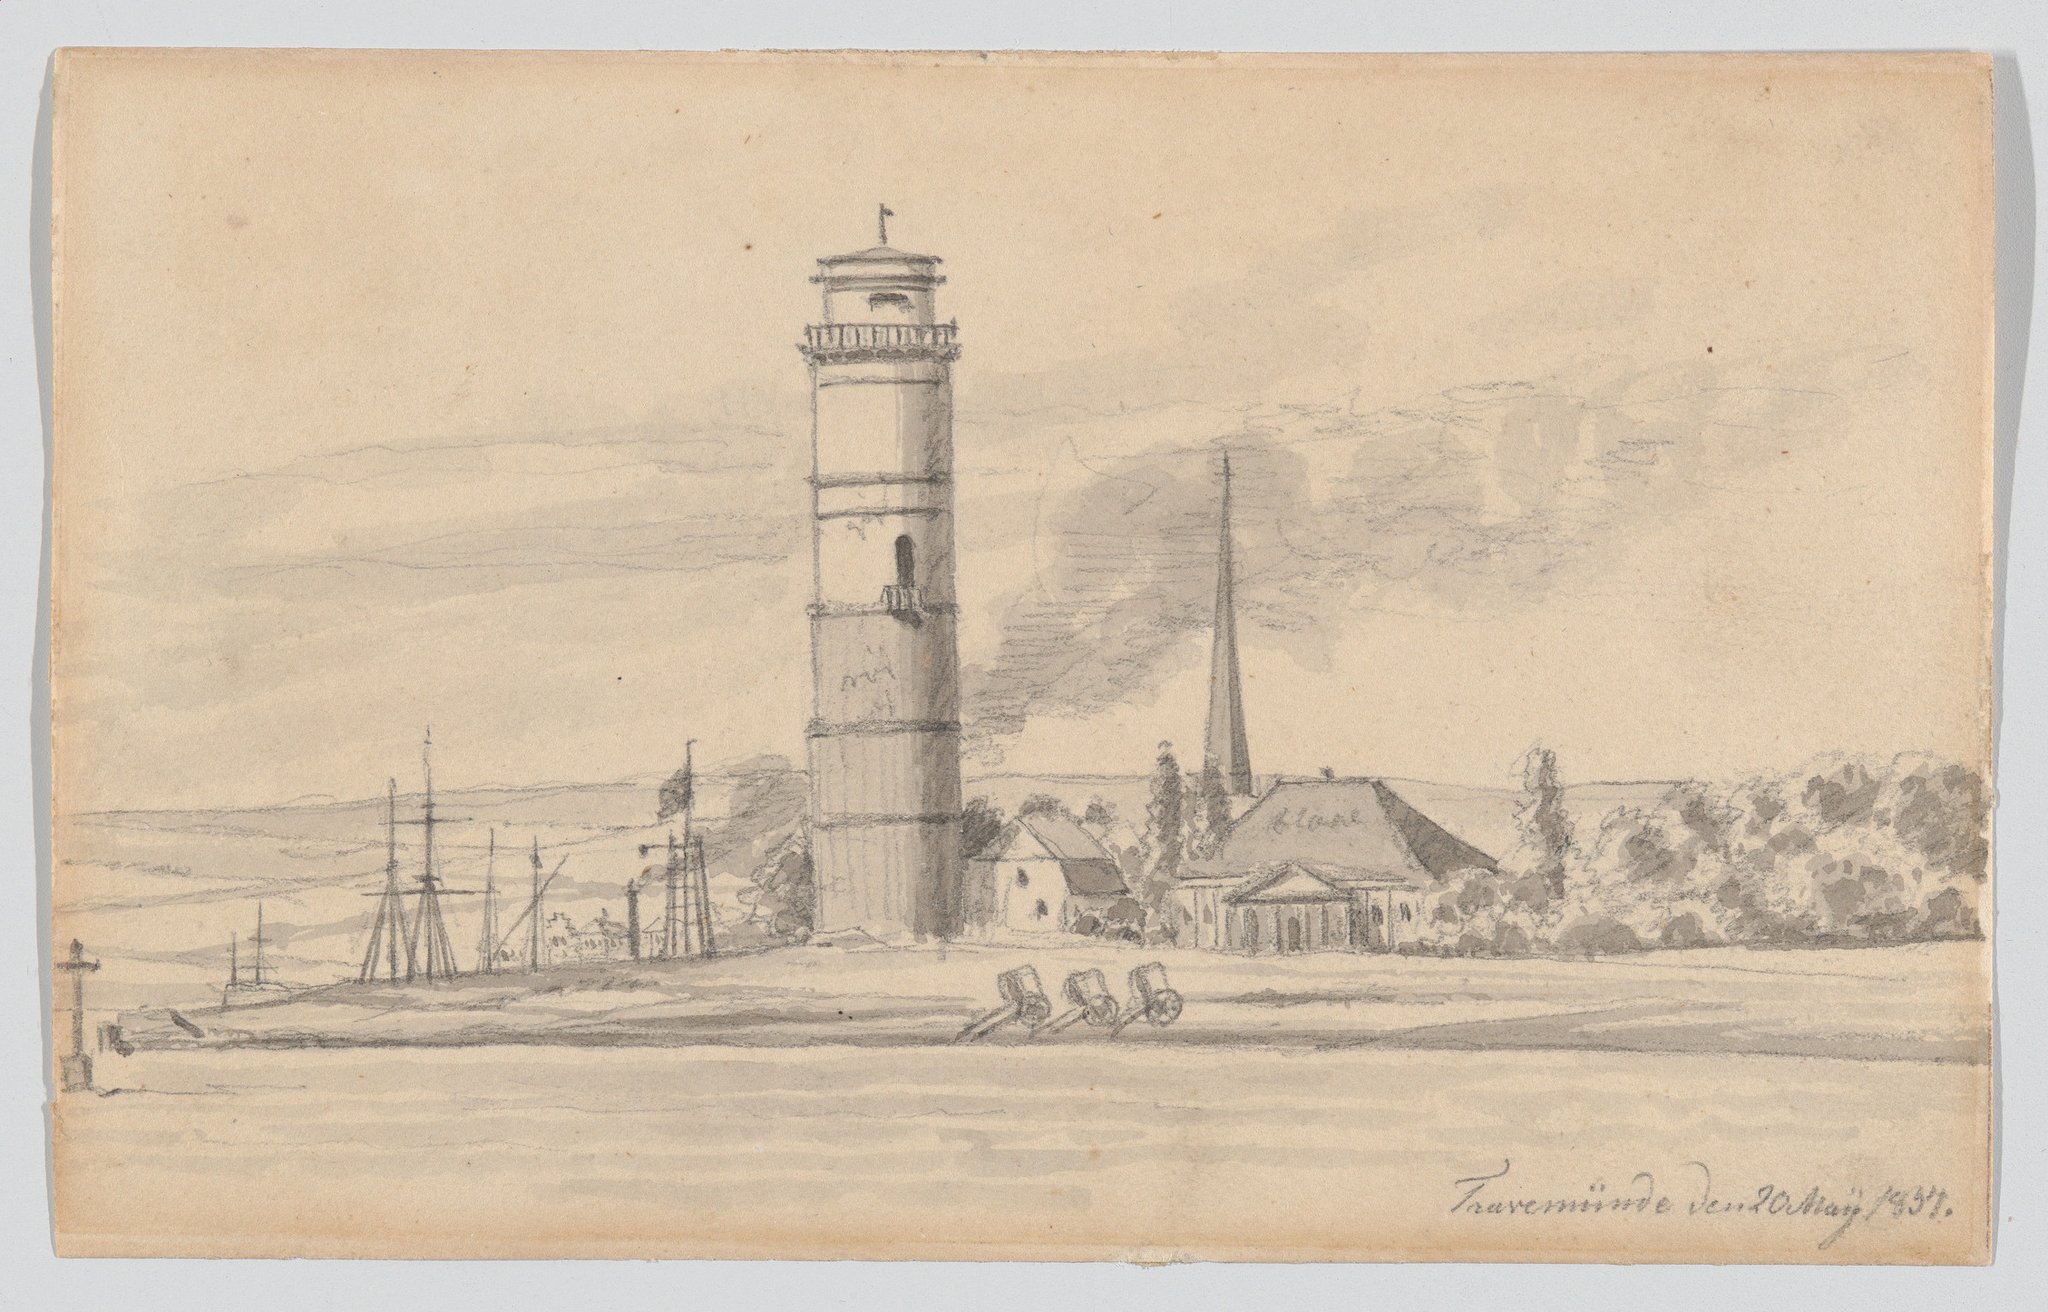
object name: drawing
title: The Lighthouse of Travemünde Seen from the South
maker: martinus rørbye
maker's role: artist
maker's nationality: danish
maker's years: 1803-1848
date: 1834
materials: graphite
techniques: wash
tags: towers